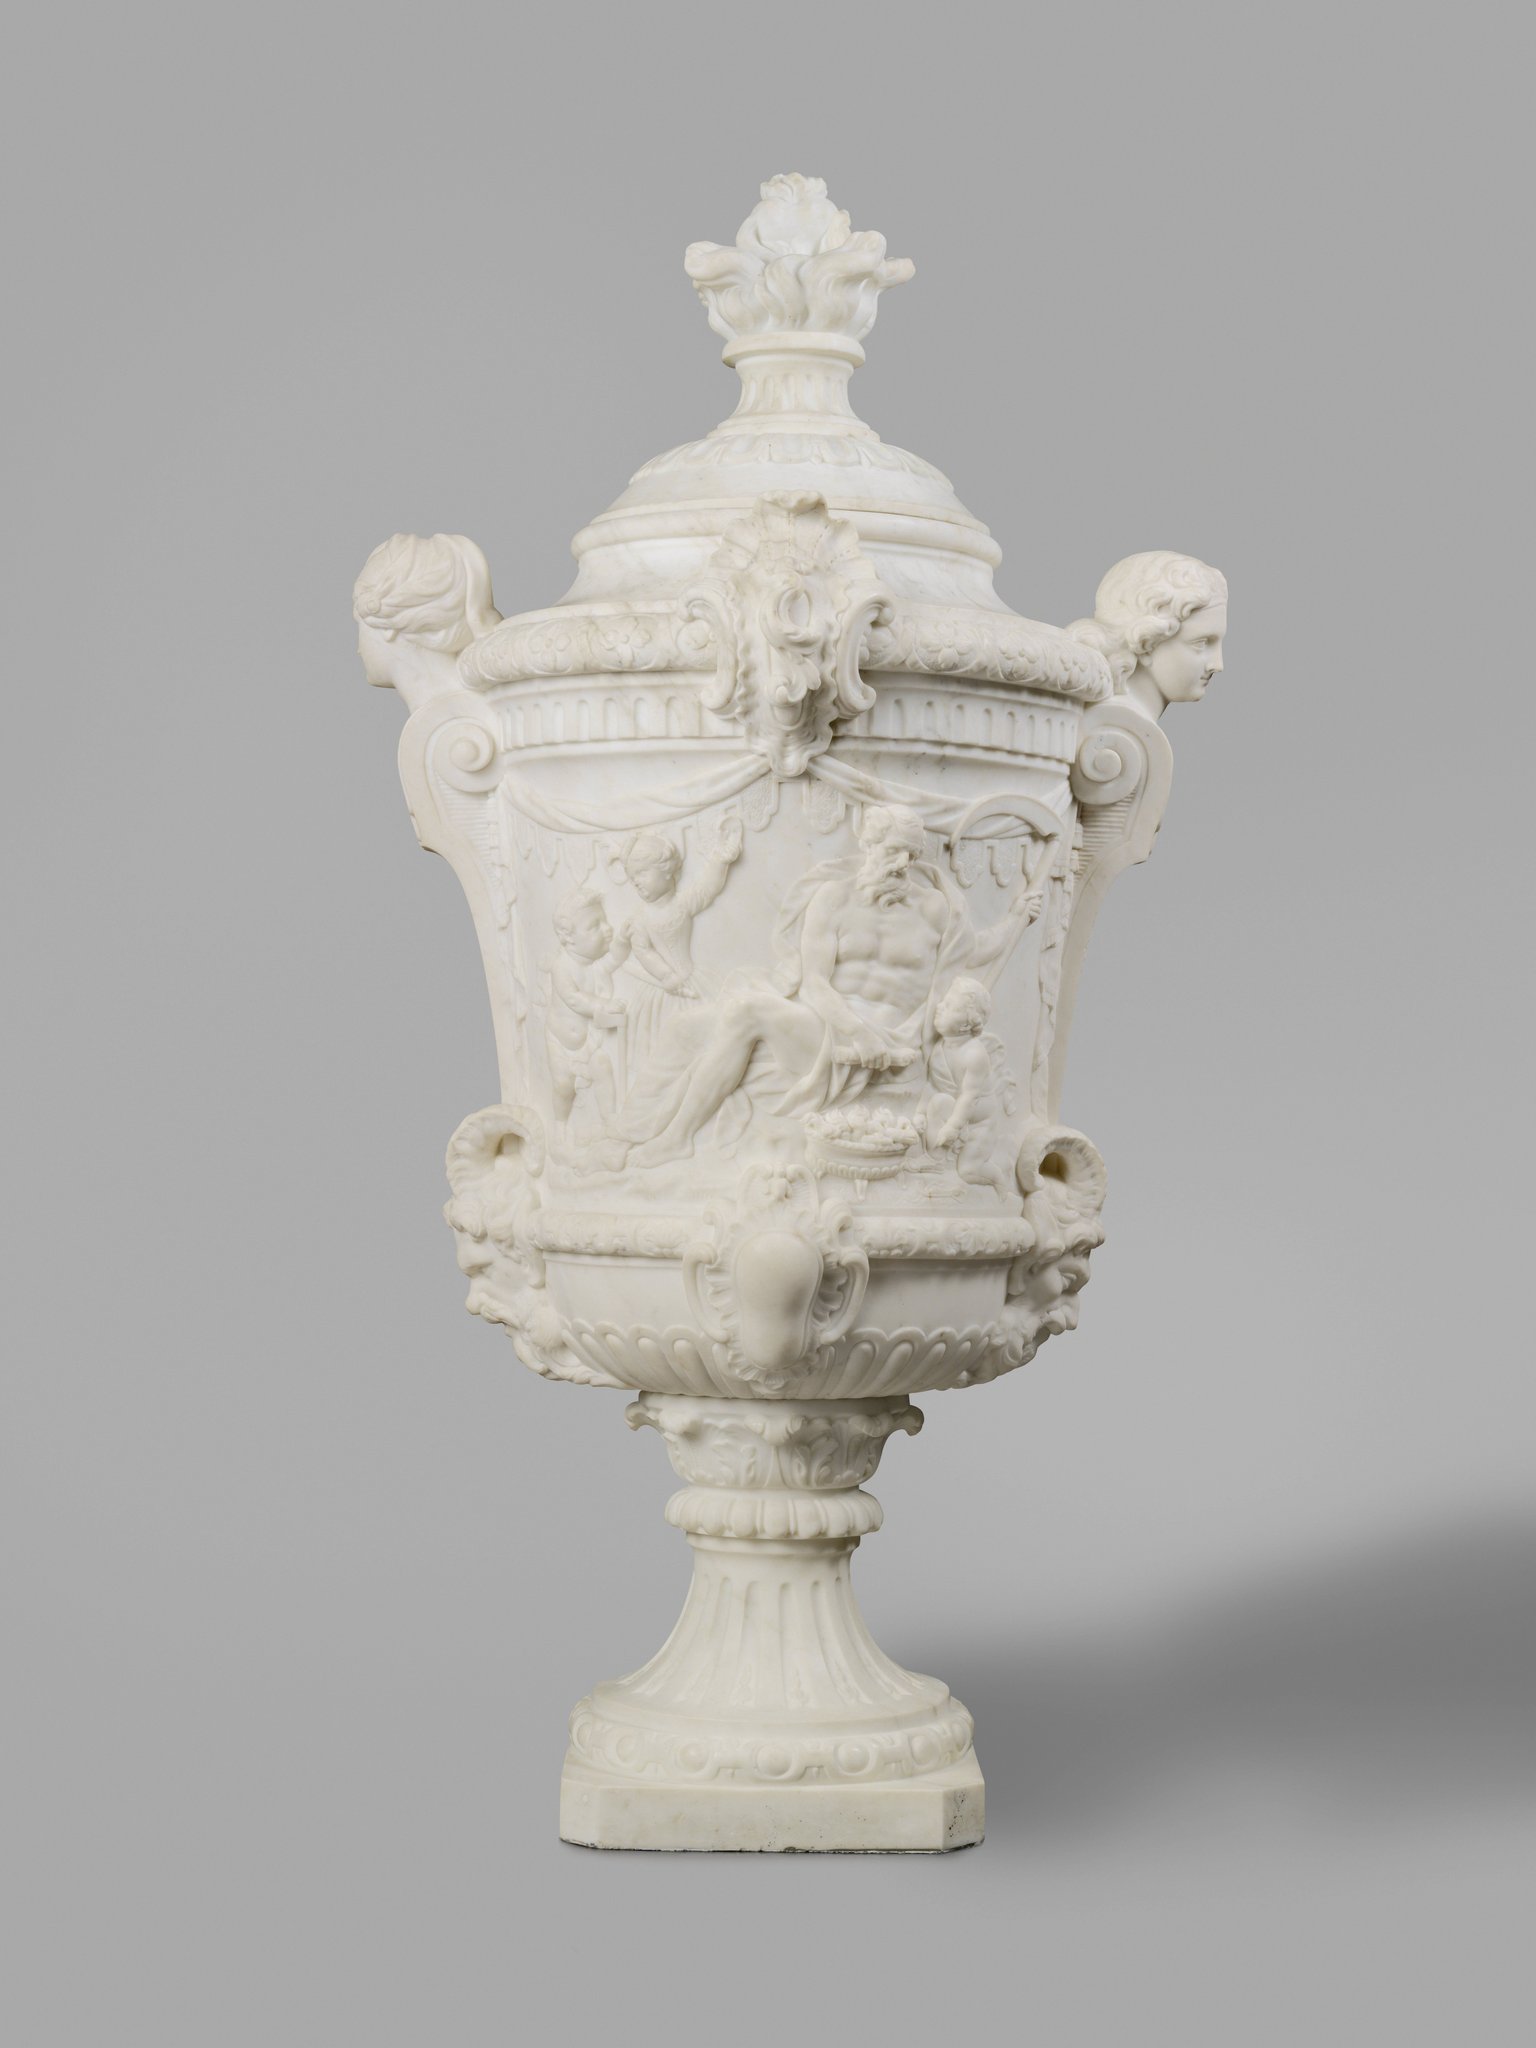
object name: garden vase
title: Garden Vase with Allegories of Autumn and Summer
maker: jacob cressant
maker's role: sculptor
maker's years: 1685-1759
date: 1714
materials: marble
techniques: carved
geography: utrecht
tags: ornament ~ hybrid beings; human and animal forms mixed, summer, 'aestas'; 'estate' (ripa), cupids: 'amores', 'amoretti', 'putti', autumn, fall, 'autumnus'; 'autunno' (ripa)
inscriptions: signature, below the relief representing Summer, incised and gilded: ‘I.CRESSANT. F. ANNO 1714’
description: These two vases were almost certainly made for the Elsenburg country estate in Maarssen, the property of Amsterdam merchant Theodoor de Leeuw. The classical shape is decorated in several places with asymmetrical ornaments that herald the Rococo style. Examples are the large scrolls above the reliefs representing the seasons.